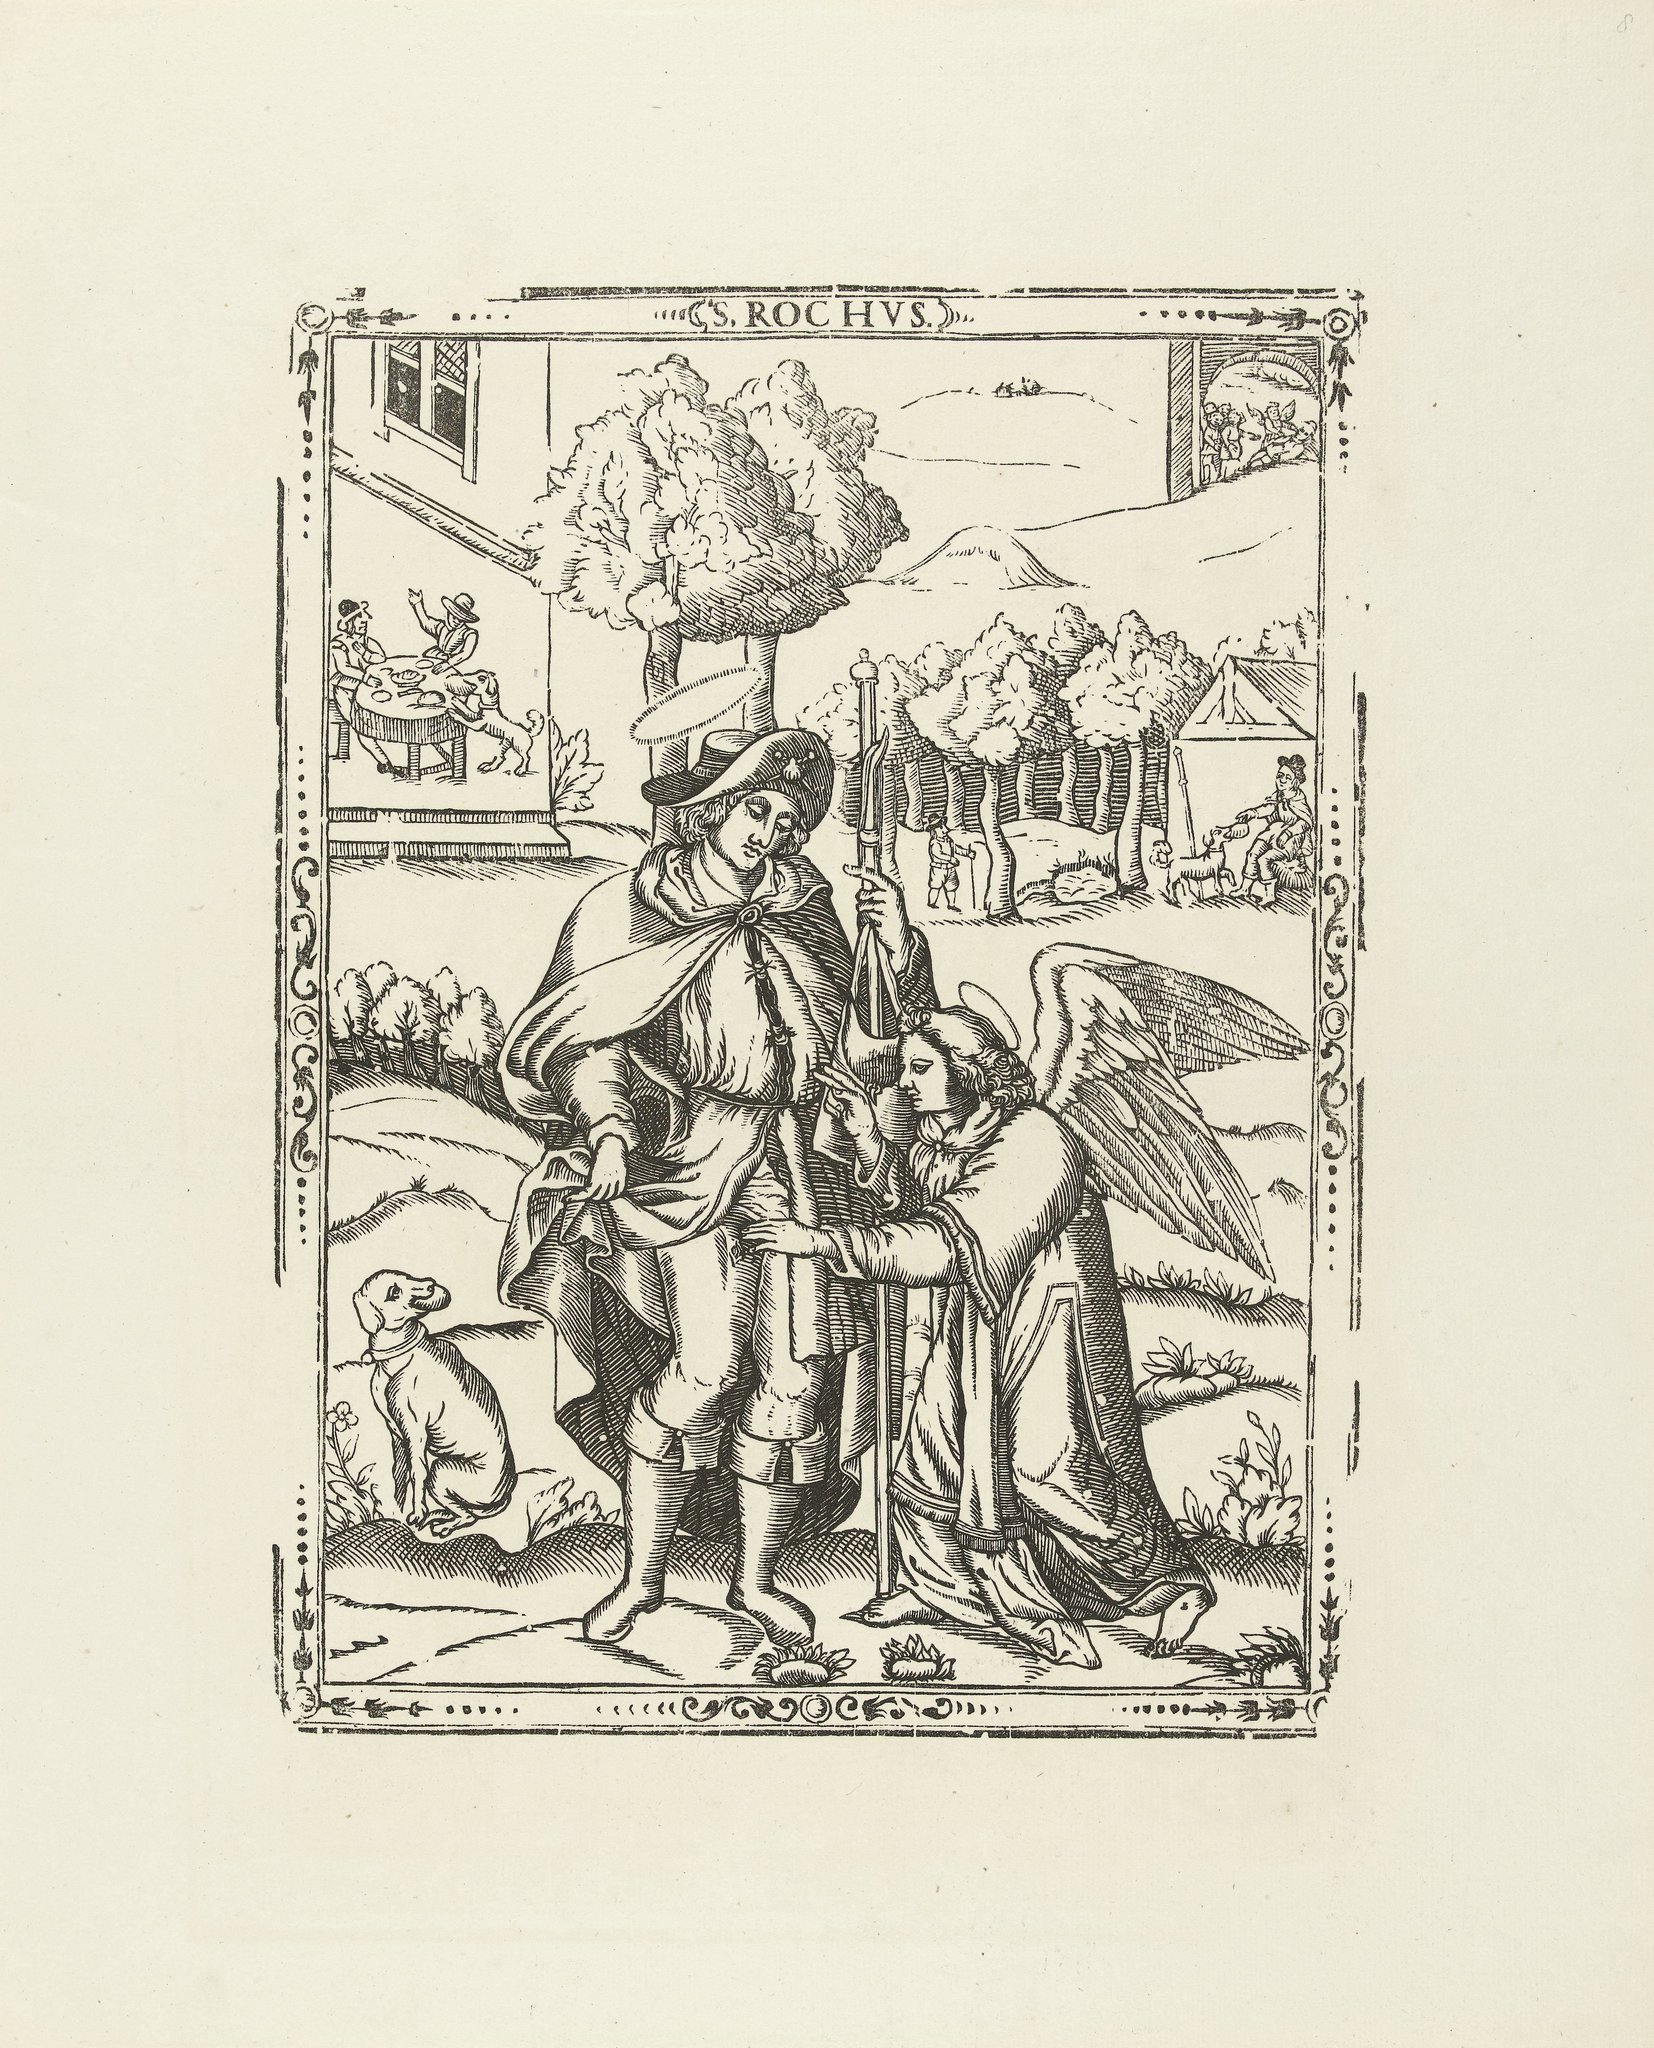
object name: popular print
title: S. Rochvs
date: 1700-1725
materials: paper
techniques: woodcut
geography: southern netherlands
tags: the confessor and pilgrim roch(us) (rocco, rock) of montpellier; possible attributes: angel (with ointment box or spoon), dog (sometimes with loaf), (pointing at) plague-spot on thigh, pilgrim's shell, staff, hat and wallet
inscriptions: collector's mark: Lugt 2760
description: Een knielende engel betast de pestwond in het been van de heilige Rochus, op de achtergrond episodes uit het leven van H. Rochus.